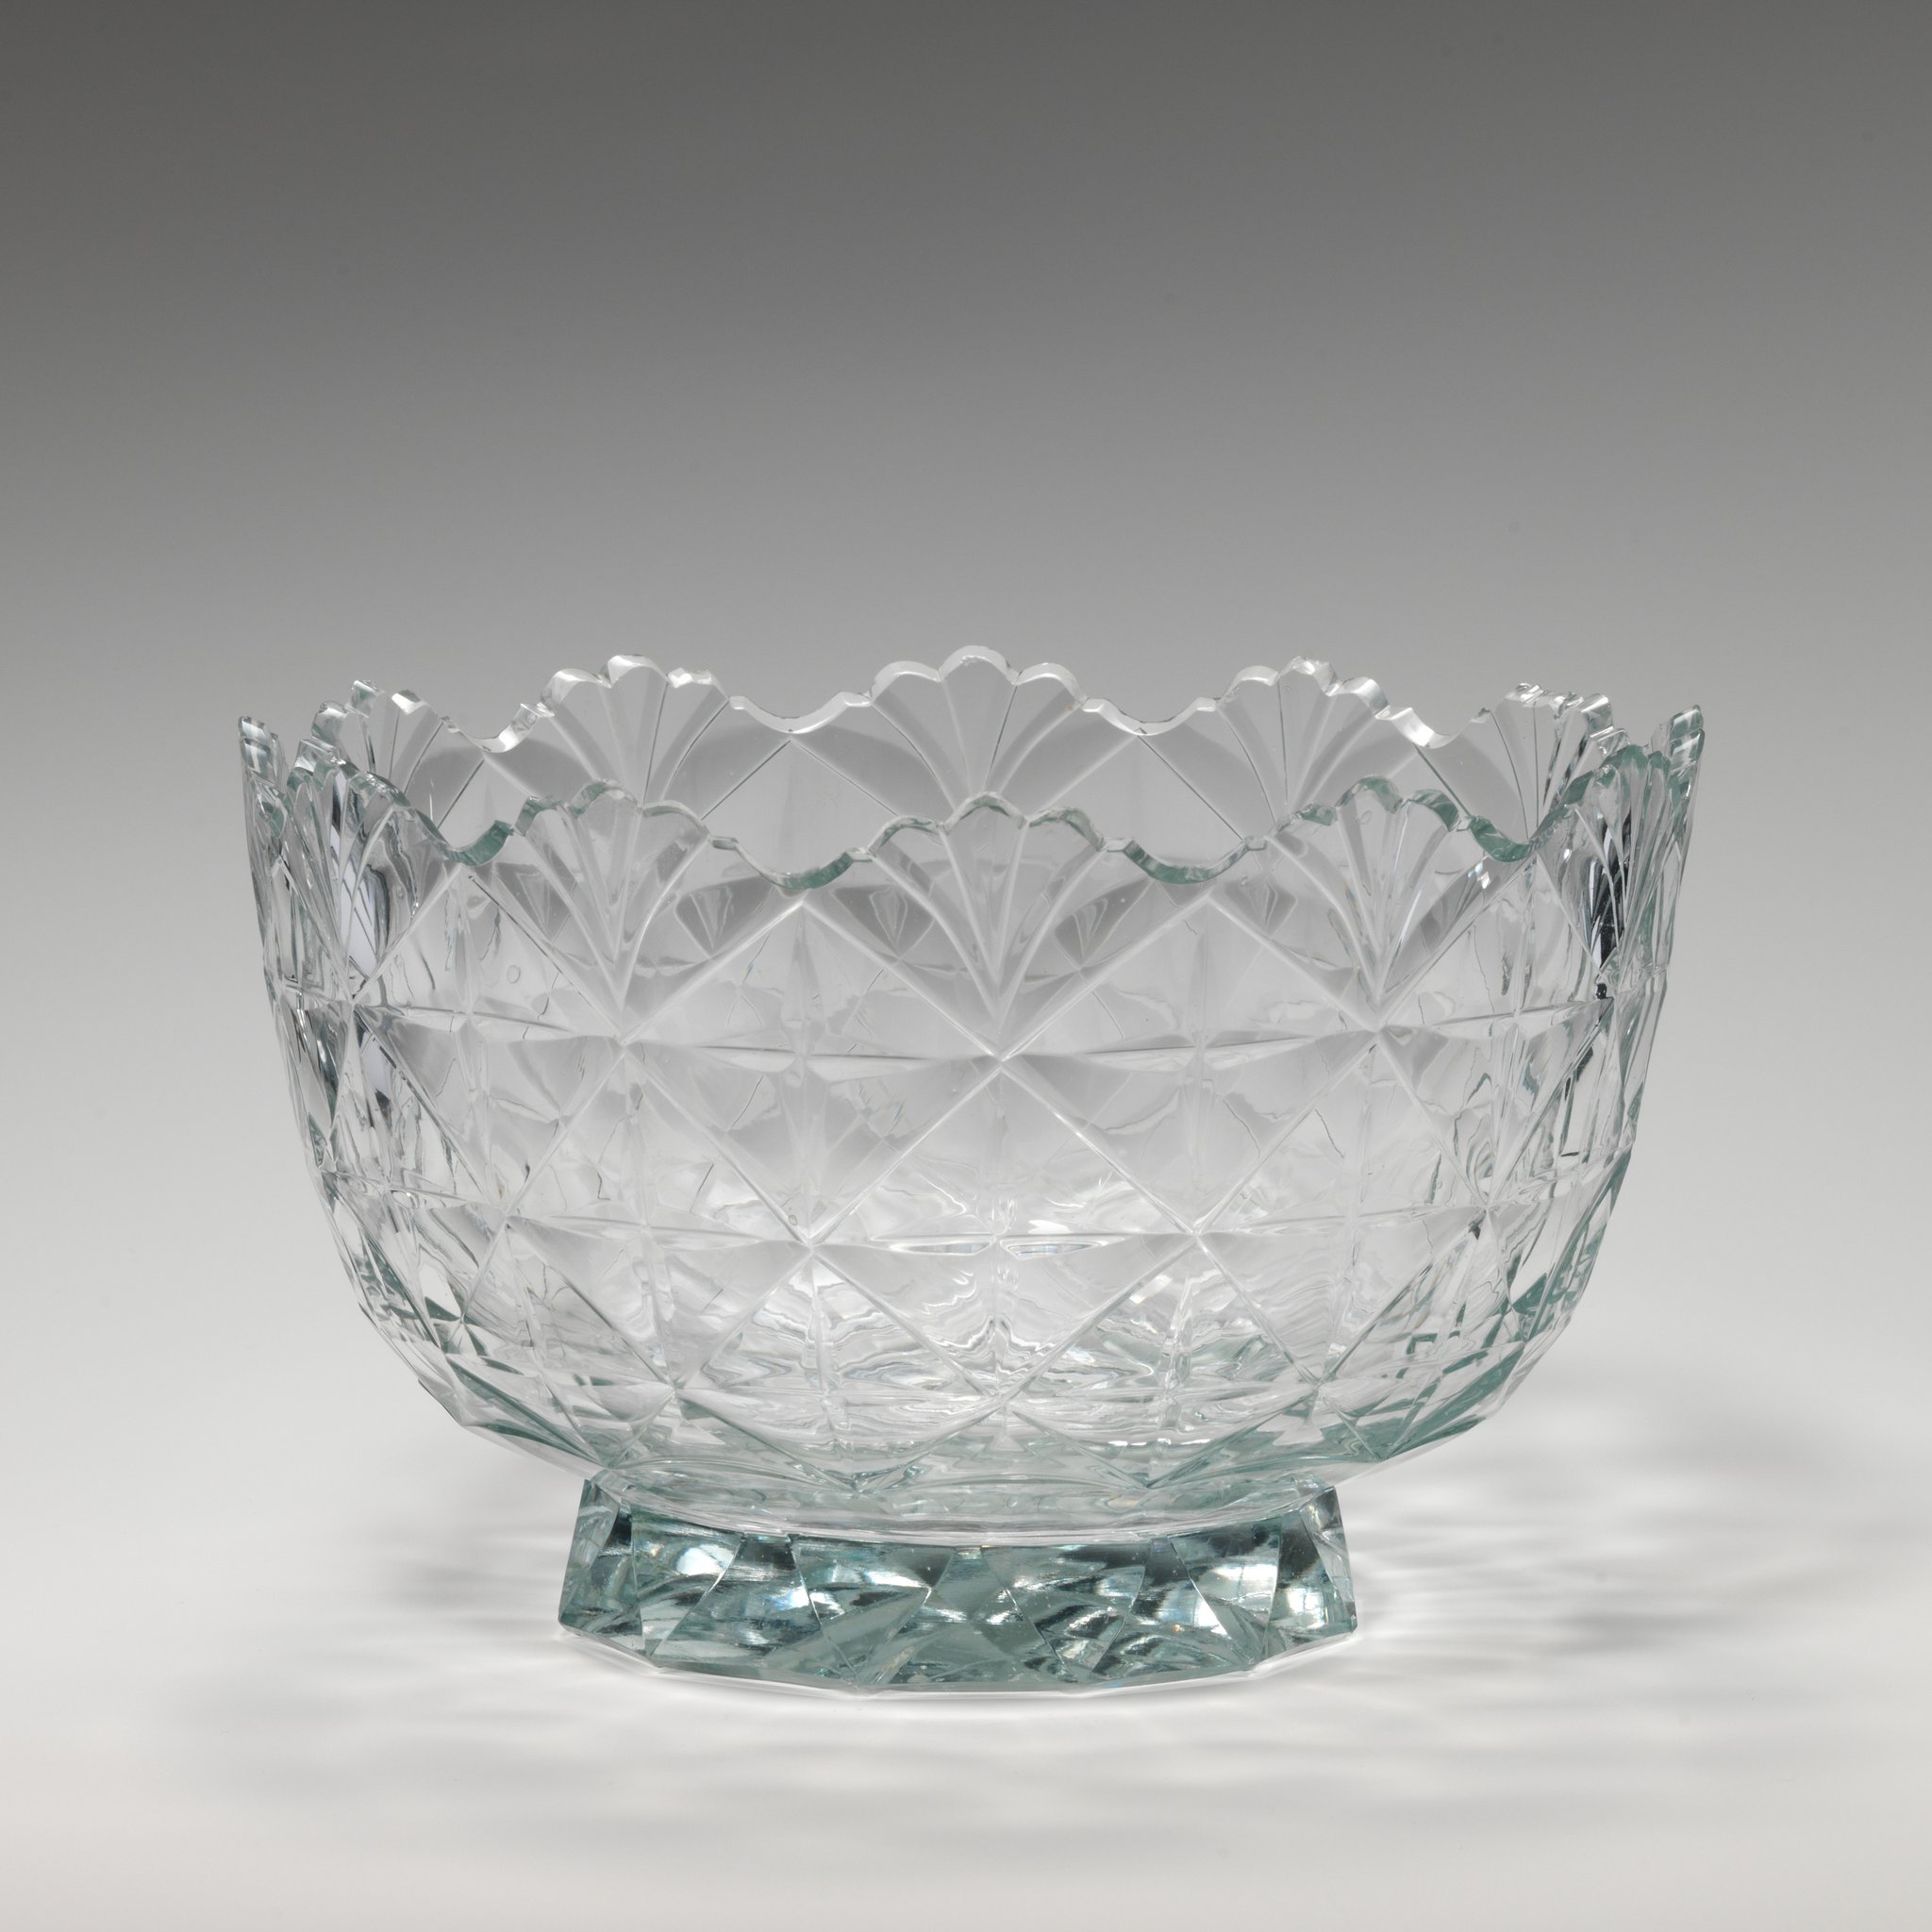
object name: bowl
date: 1801-1833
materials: glass